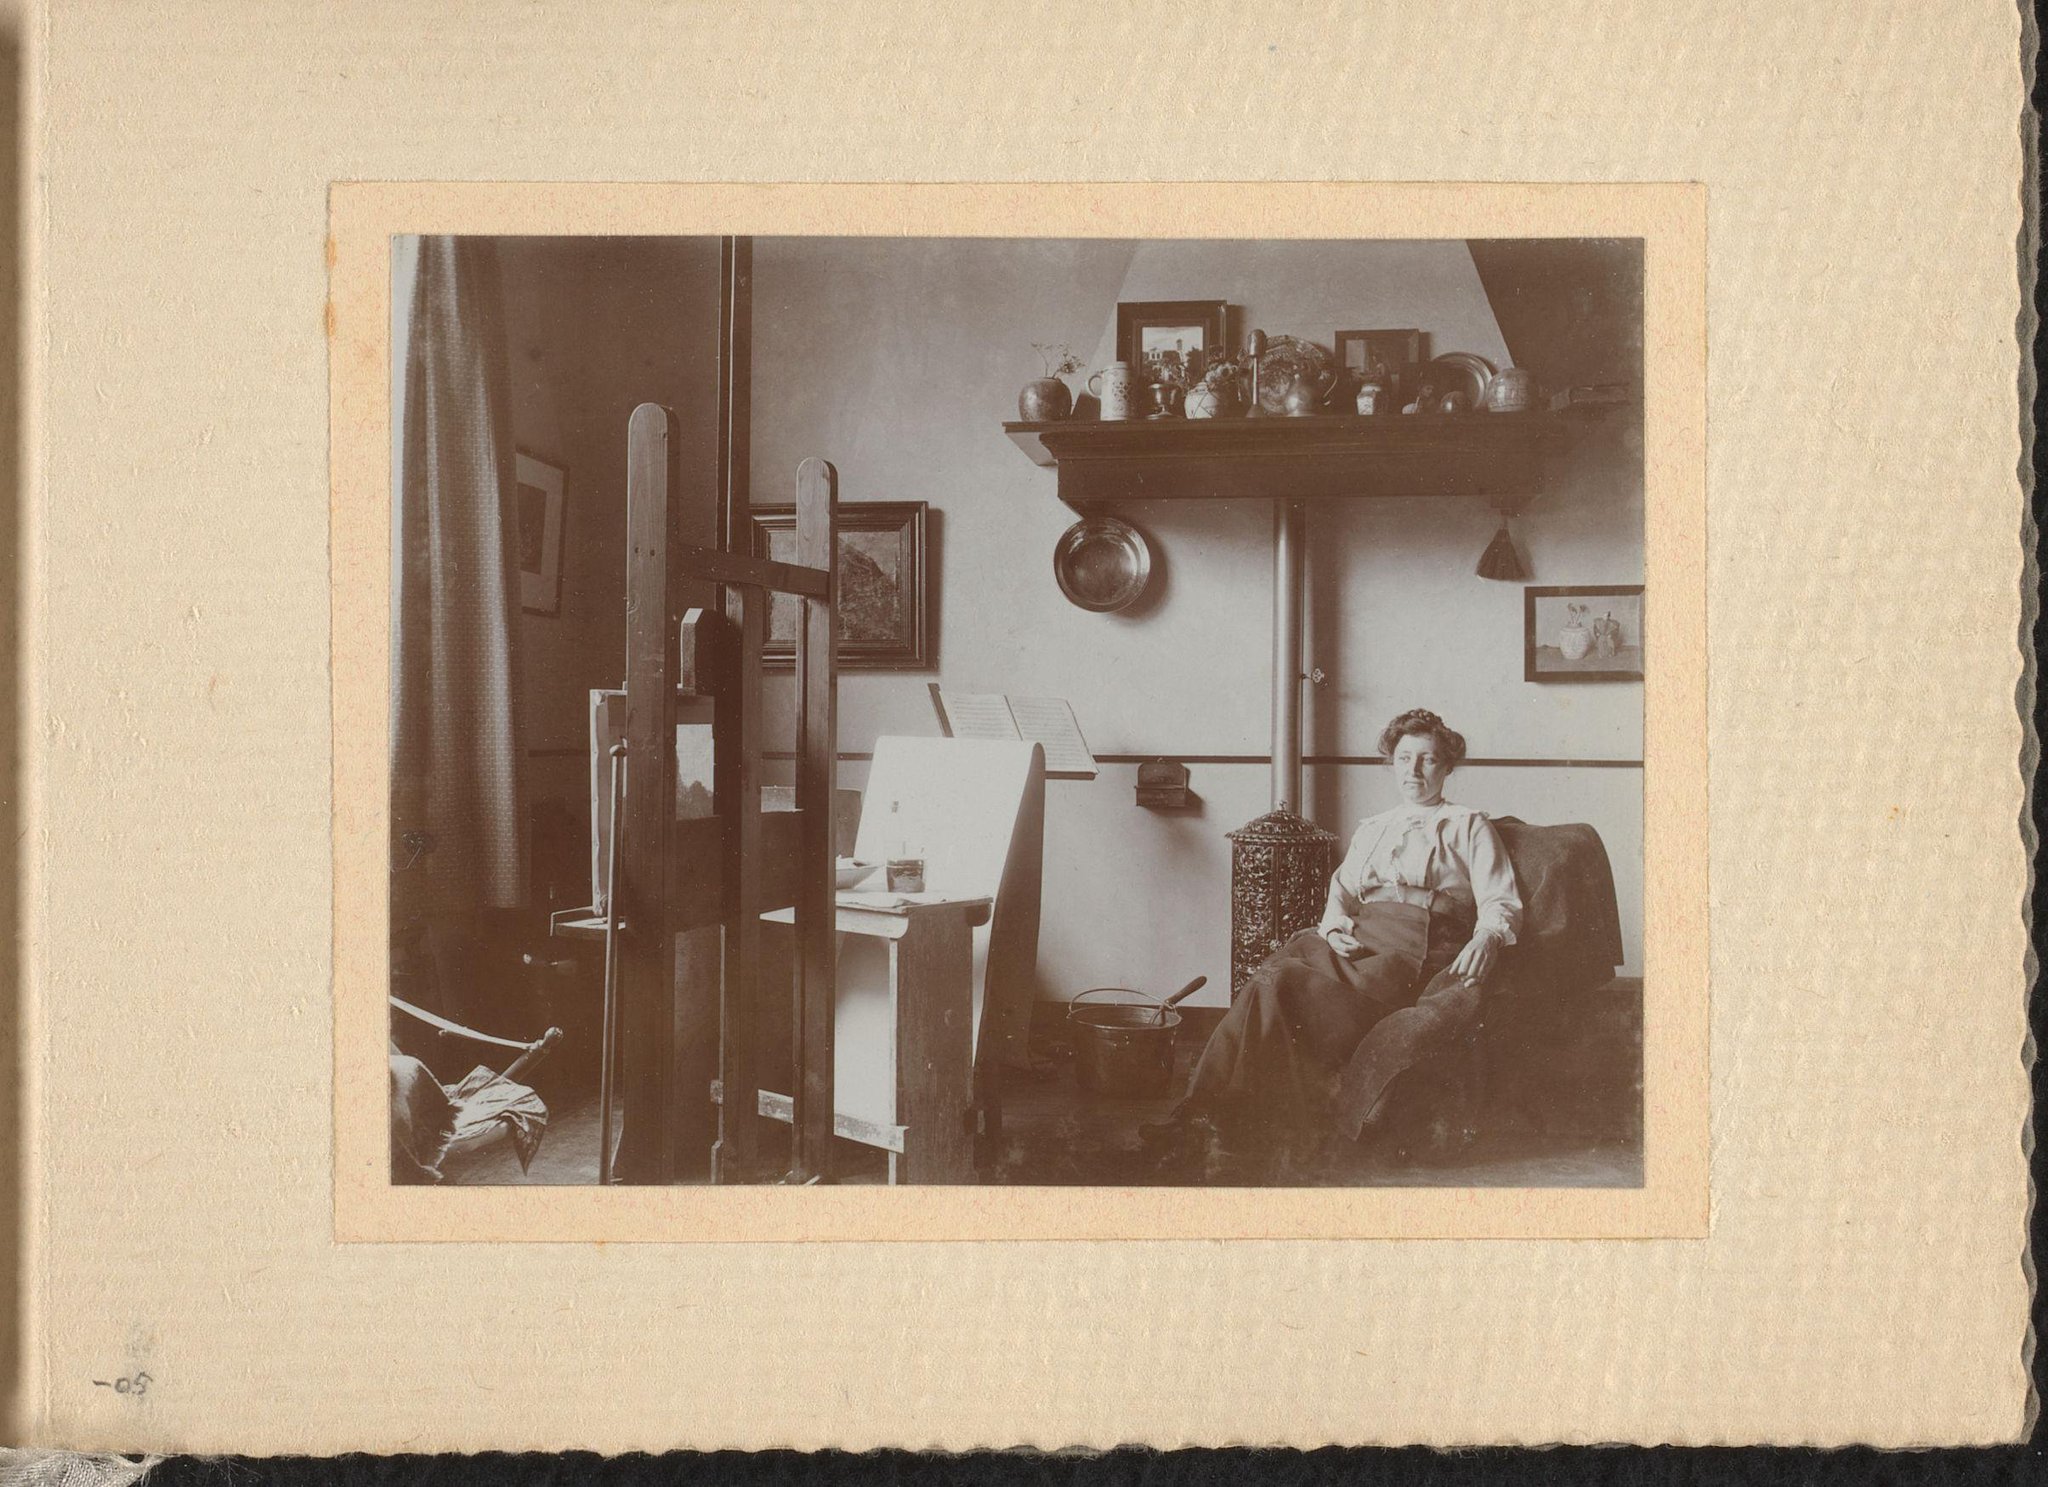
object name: photograph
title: Portret van een onbekende vrouw in het atelier van Cornelis van der Griendt in Laren, Noord-Holland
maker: cornelis van der griendt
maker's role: draughtsman, painter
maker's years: 1827-1918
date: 1895-1918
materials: paper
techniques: gelatin silver print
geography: laren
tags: delft, painter, draughtsman, cornelis van der griendt, adult woman, historical persons, villa